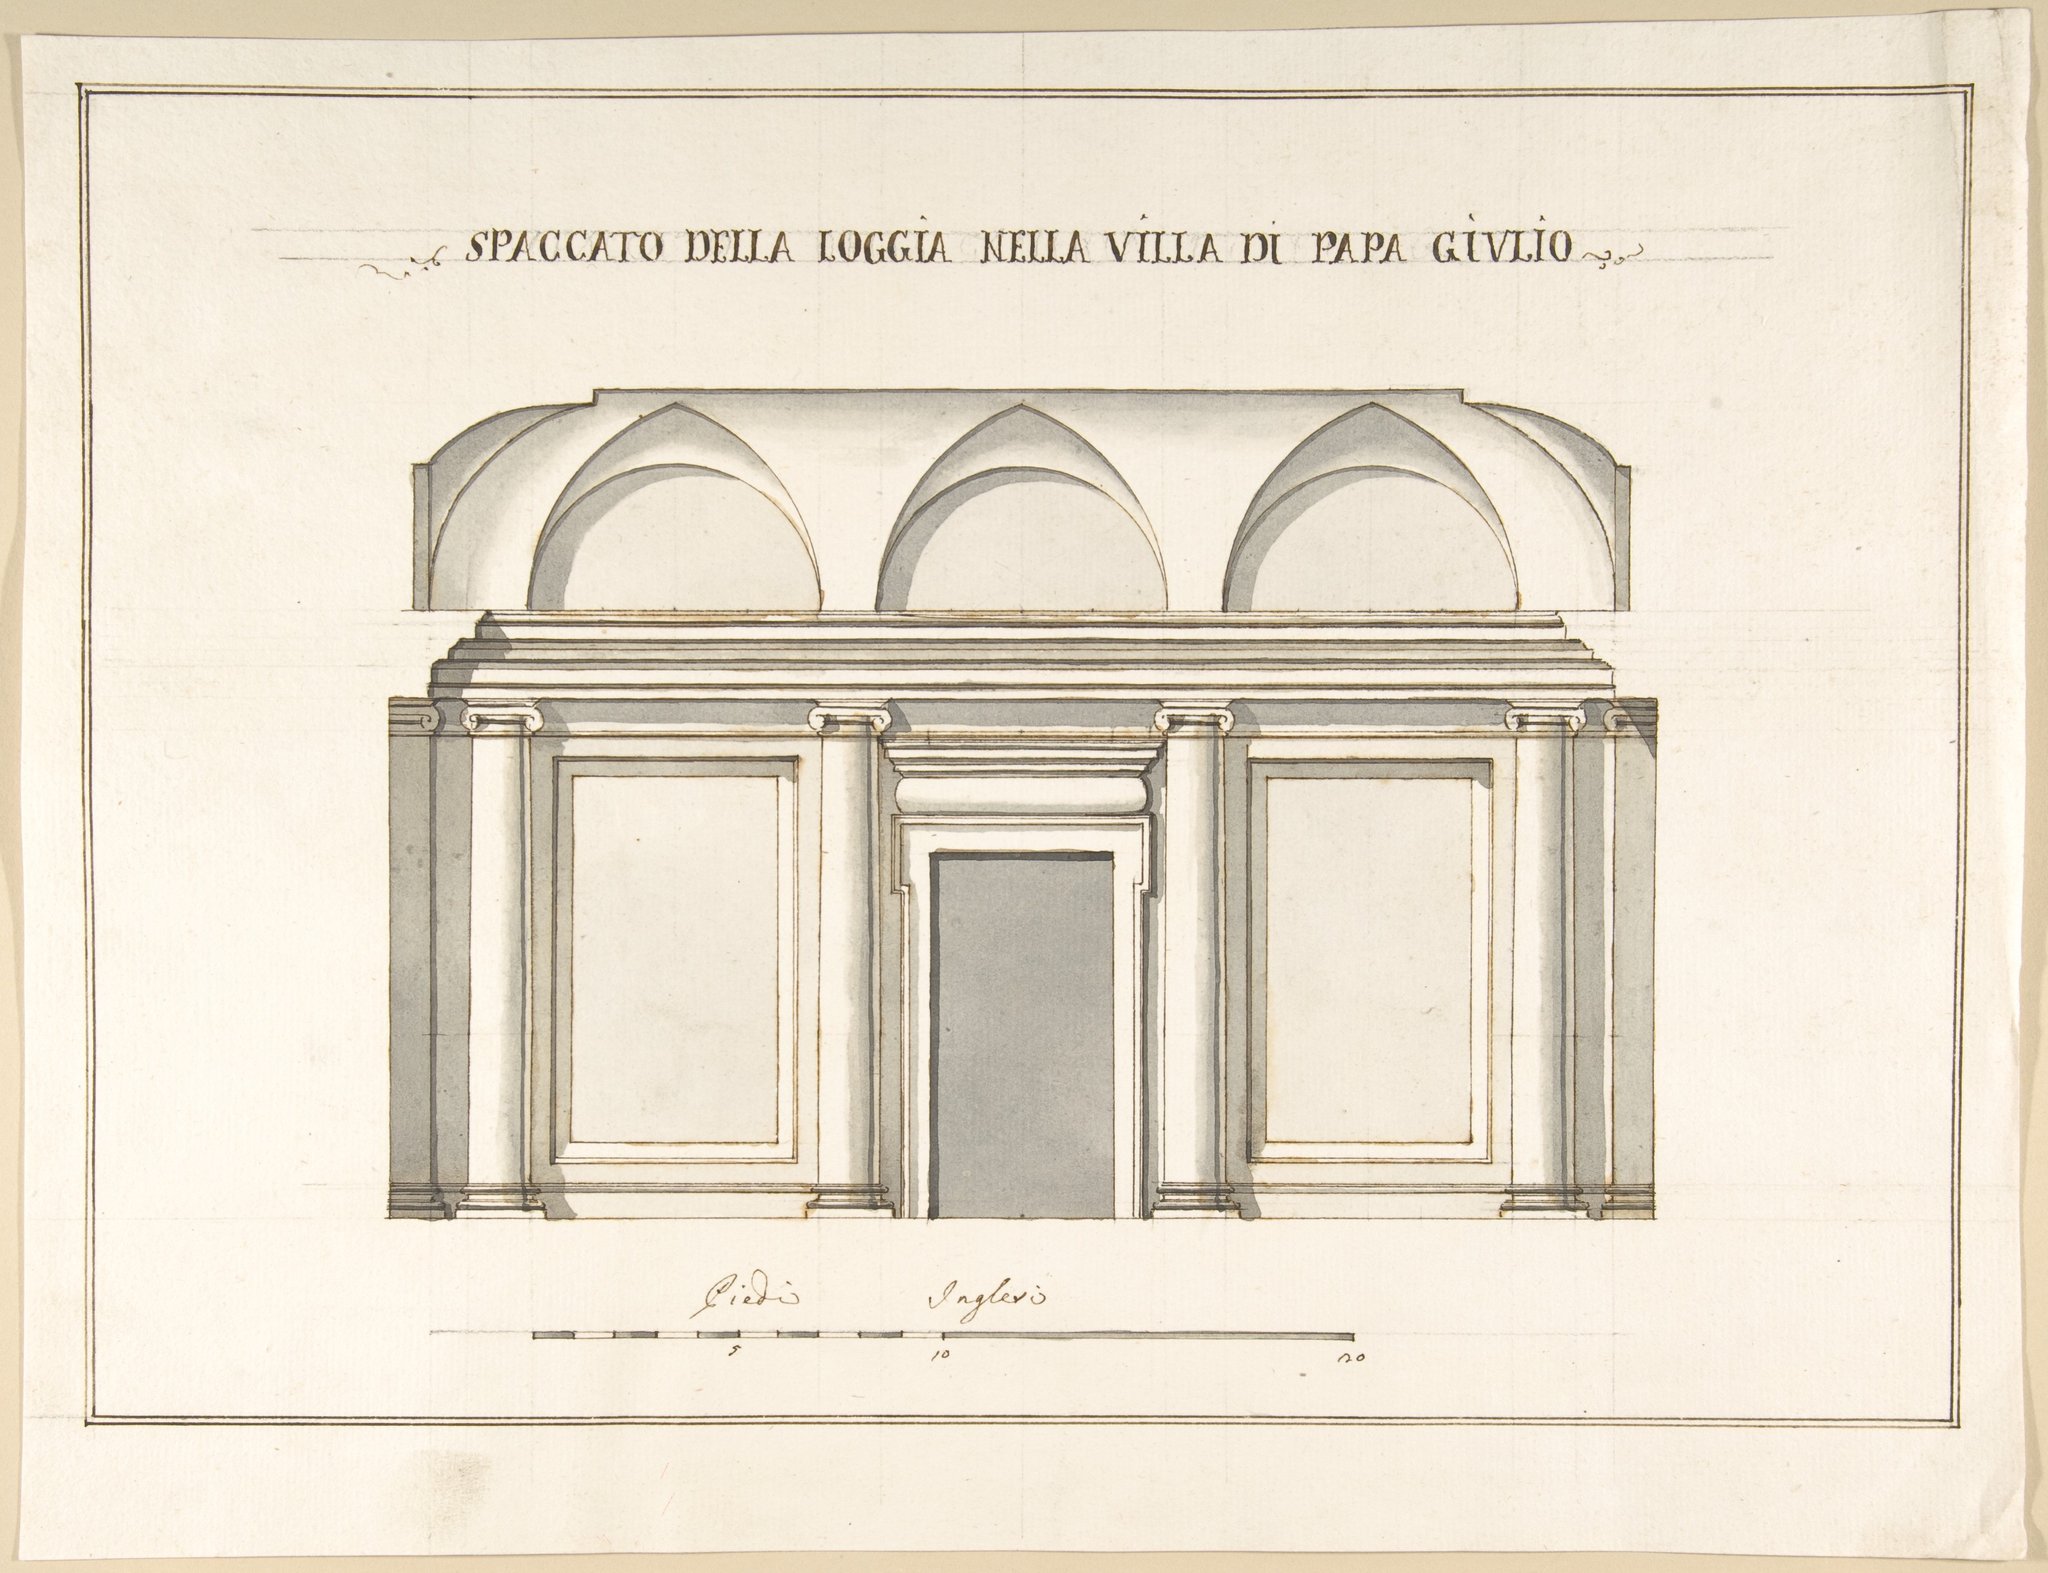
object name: drawing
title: Section of the Loggia in the Villa of Pope Julius [III.]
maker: pietro paolo coccetti (cocchetti)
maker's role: artist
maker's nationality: italian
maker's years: 1710-1727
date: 1710-1727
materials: graphite, ink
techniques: brush, pen, wash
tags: architecture